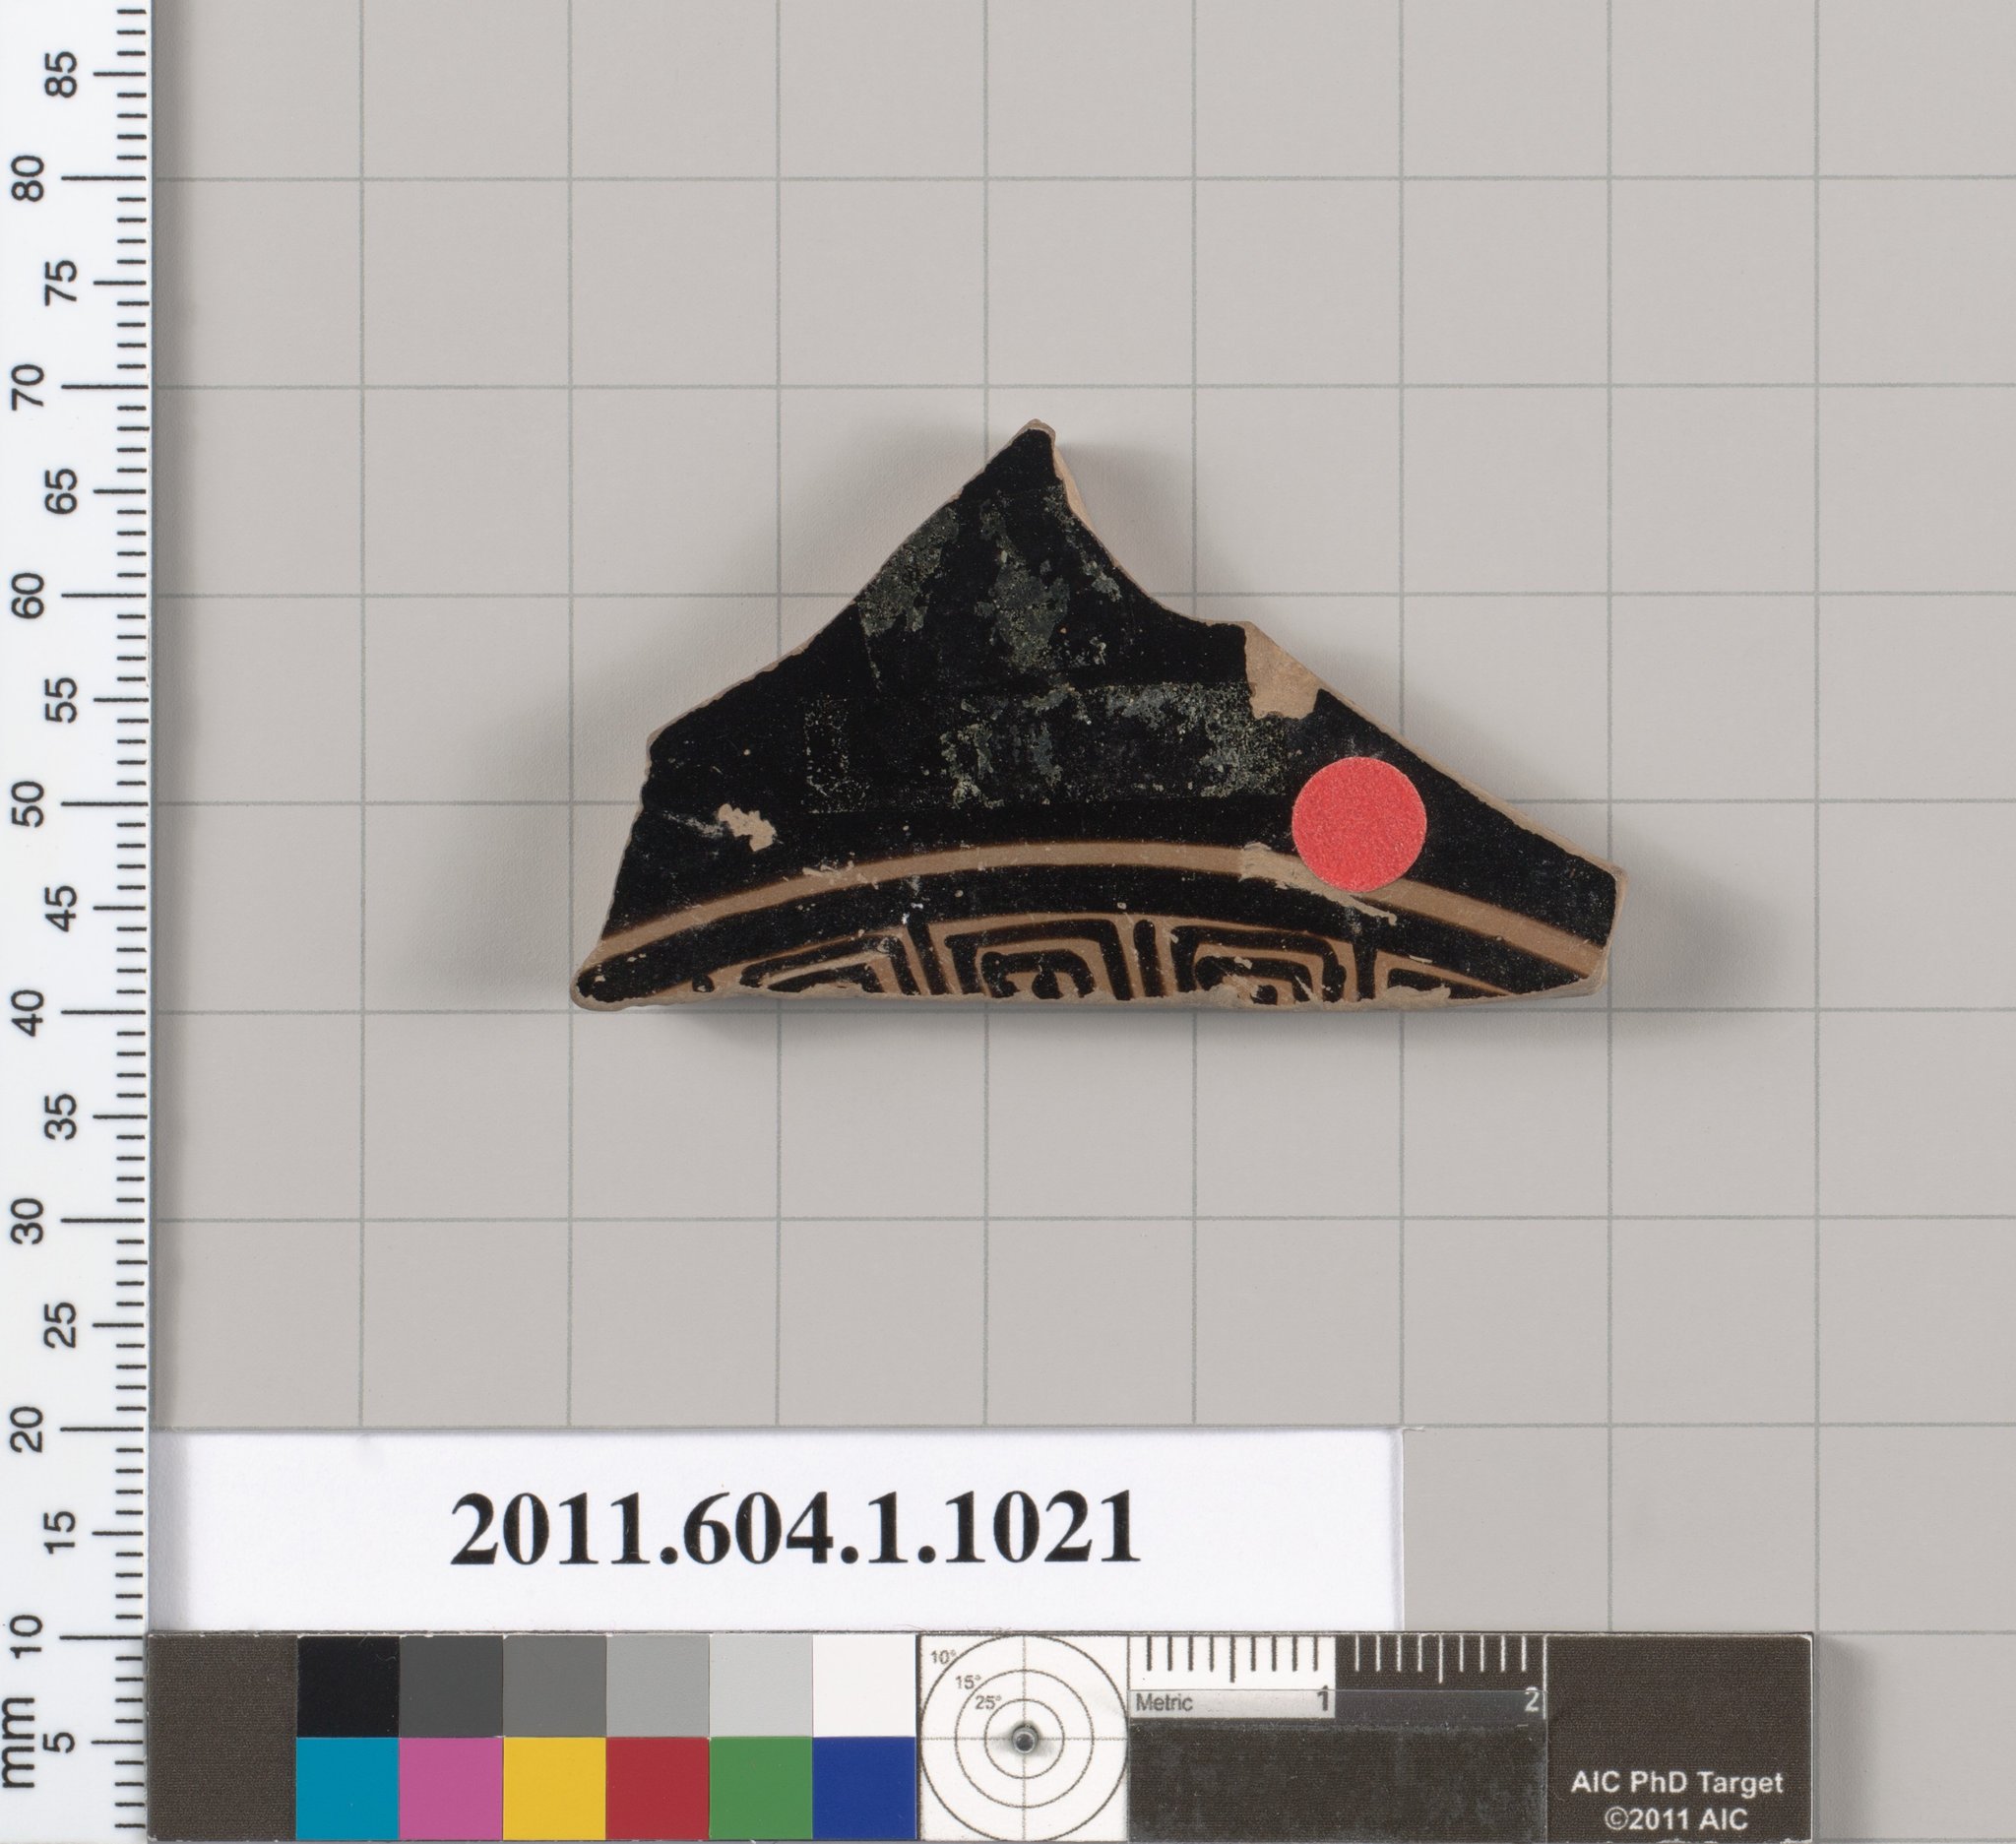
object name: kylix fragment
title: Terracotta fragment of a kylix (drinking cup)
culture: greek, attic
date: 475-451 BCE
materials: terracotta